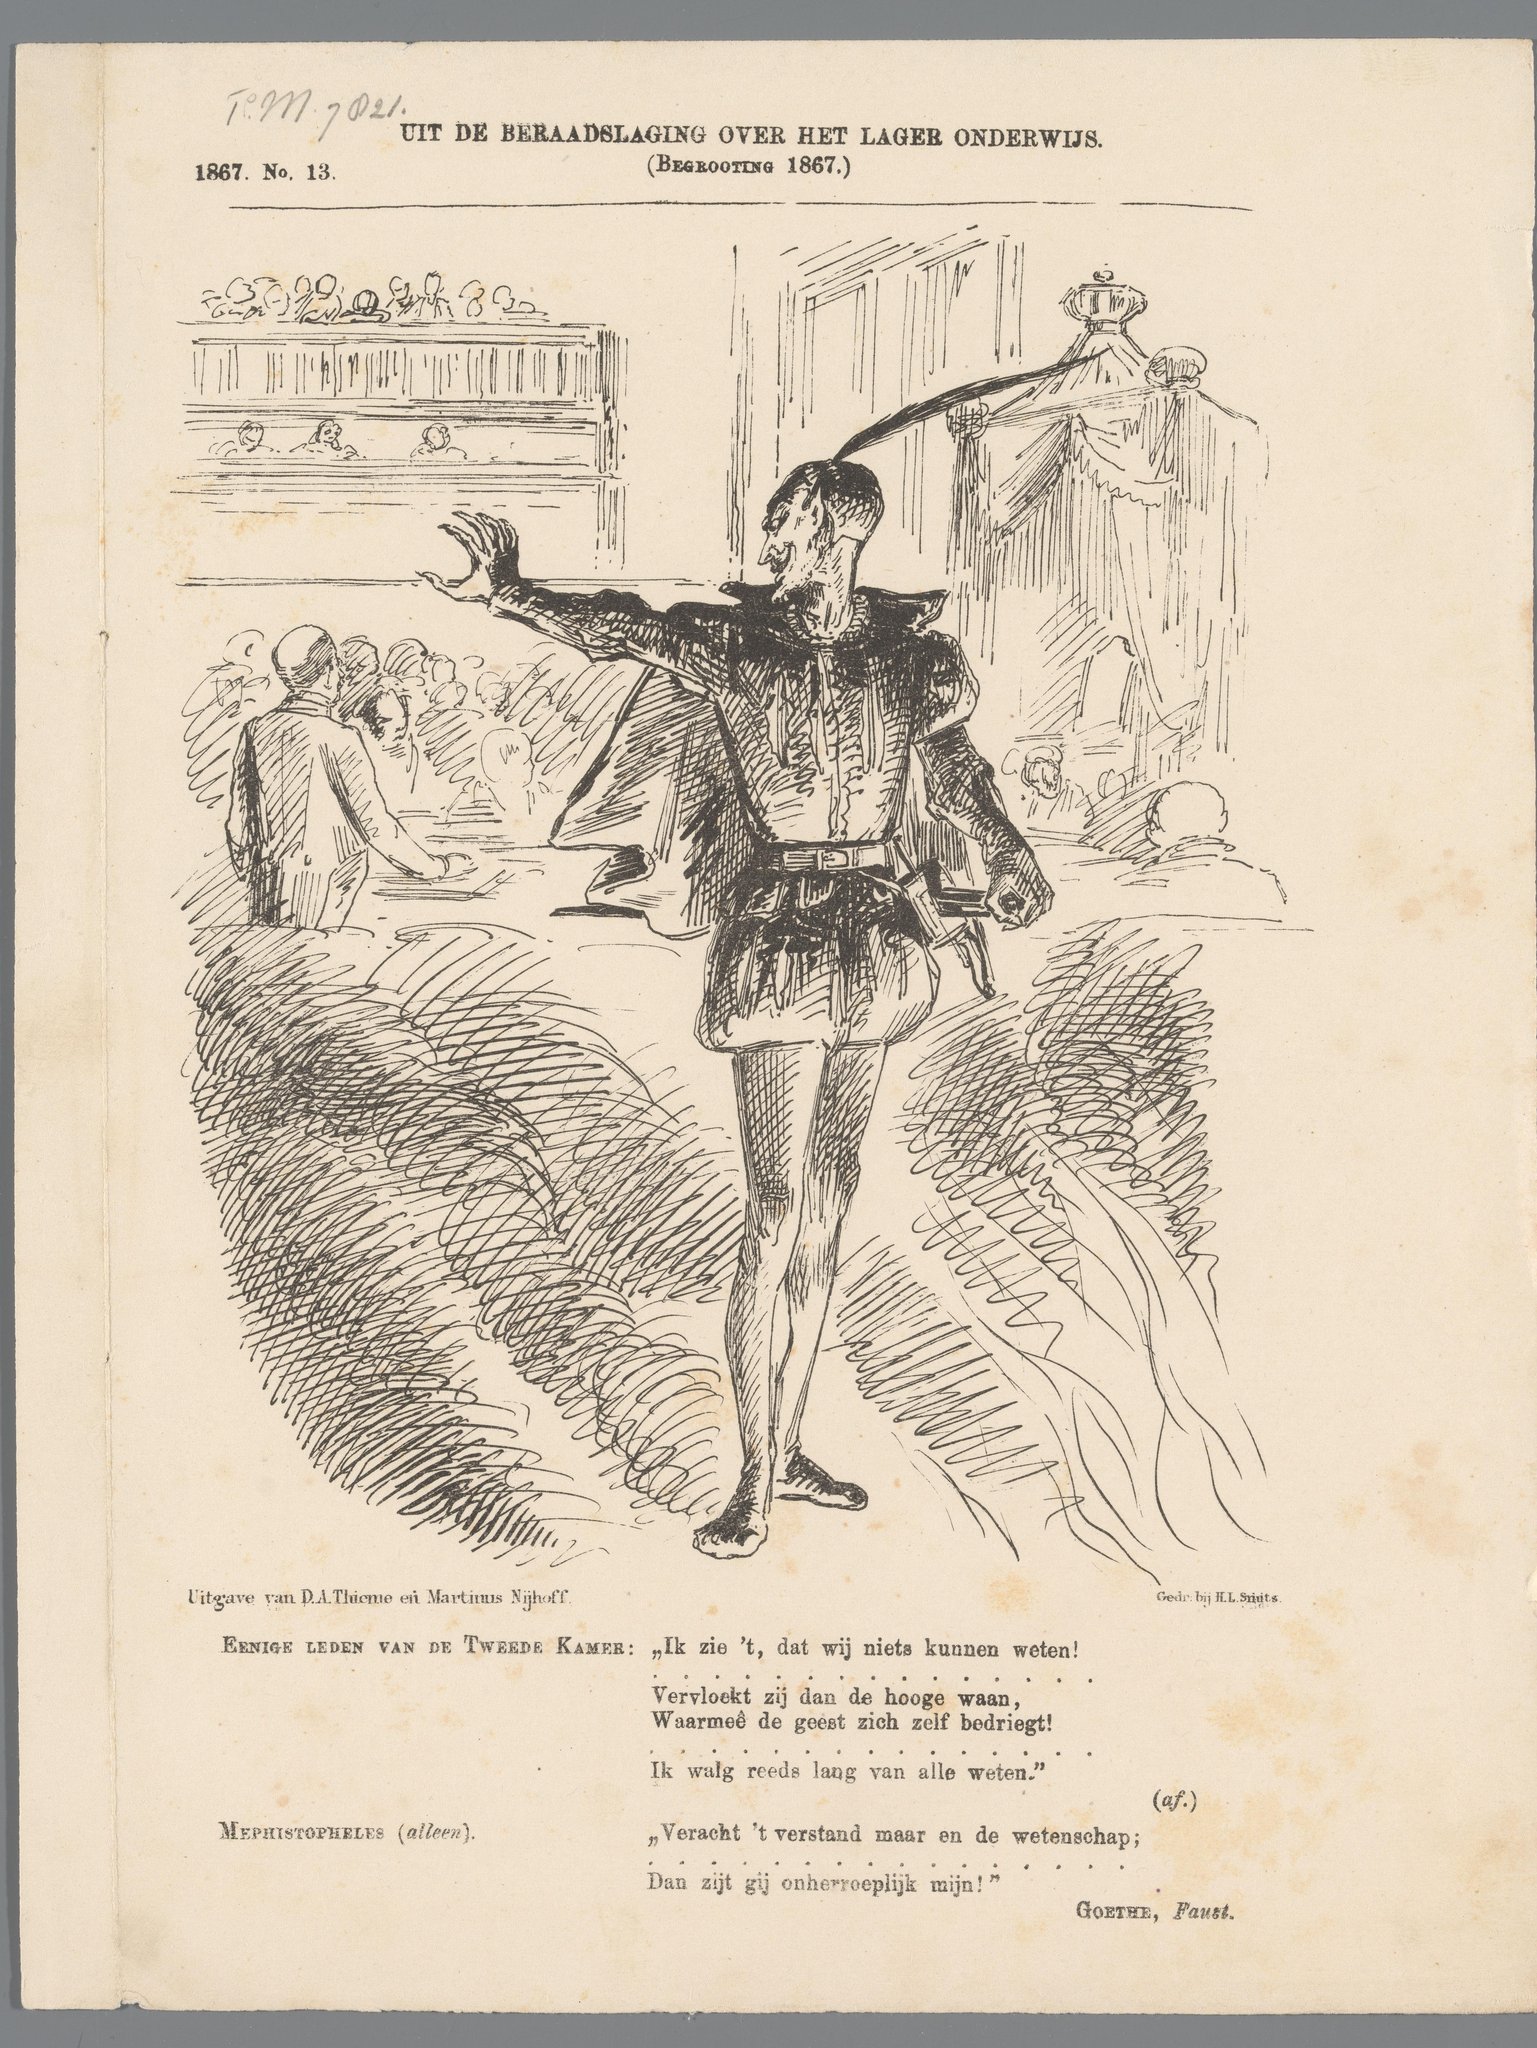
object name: cartoon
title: Uit de beraadslagingen over het lager onderwijs. (Begrooting 1867.)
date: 1867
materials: paper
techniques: lithograph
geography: the hague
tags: mephistopheles, name of the demonic tempter in the literary versions of the faust legends, elementary school; class, form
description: Spotprent over de behandeling van het lager onderwijs in de Tweede Kamer. Mephistopheles steekt zijn hand uit naar de kamerleden. Onderaan citaten uit Goethes Faust. Plaat verschenen bij het weekblad De Nederlandsche Spectator, nr. 13, 30 maart 1867.